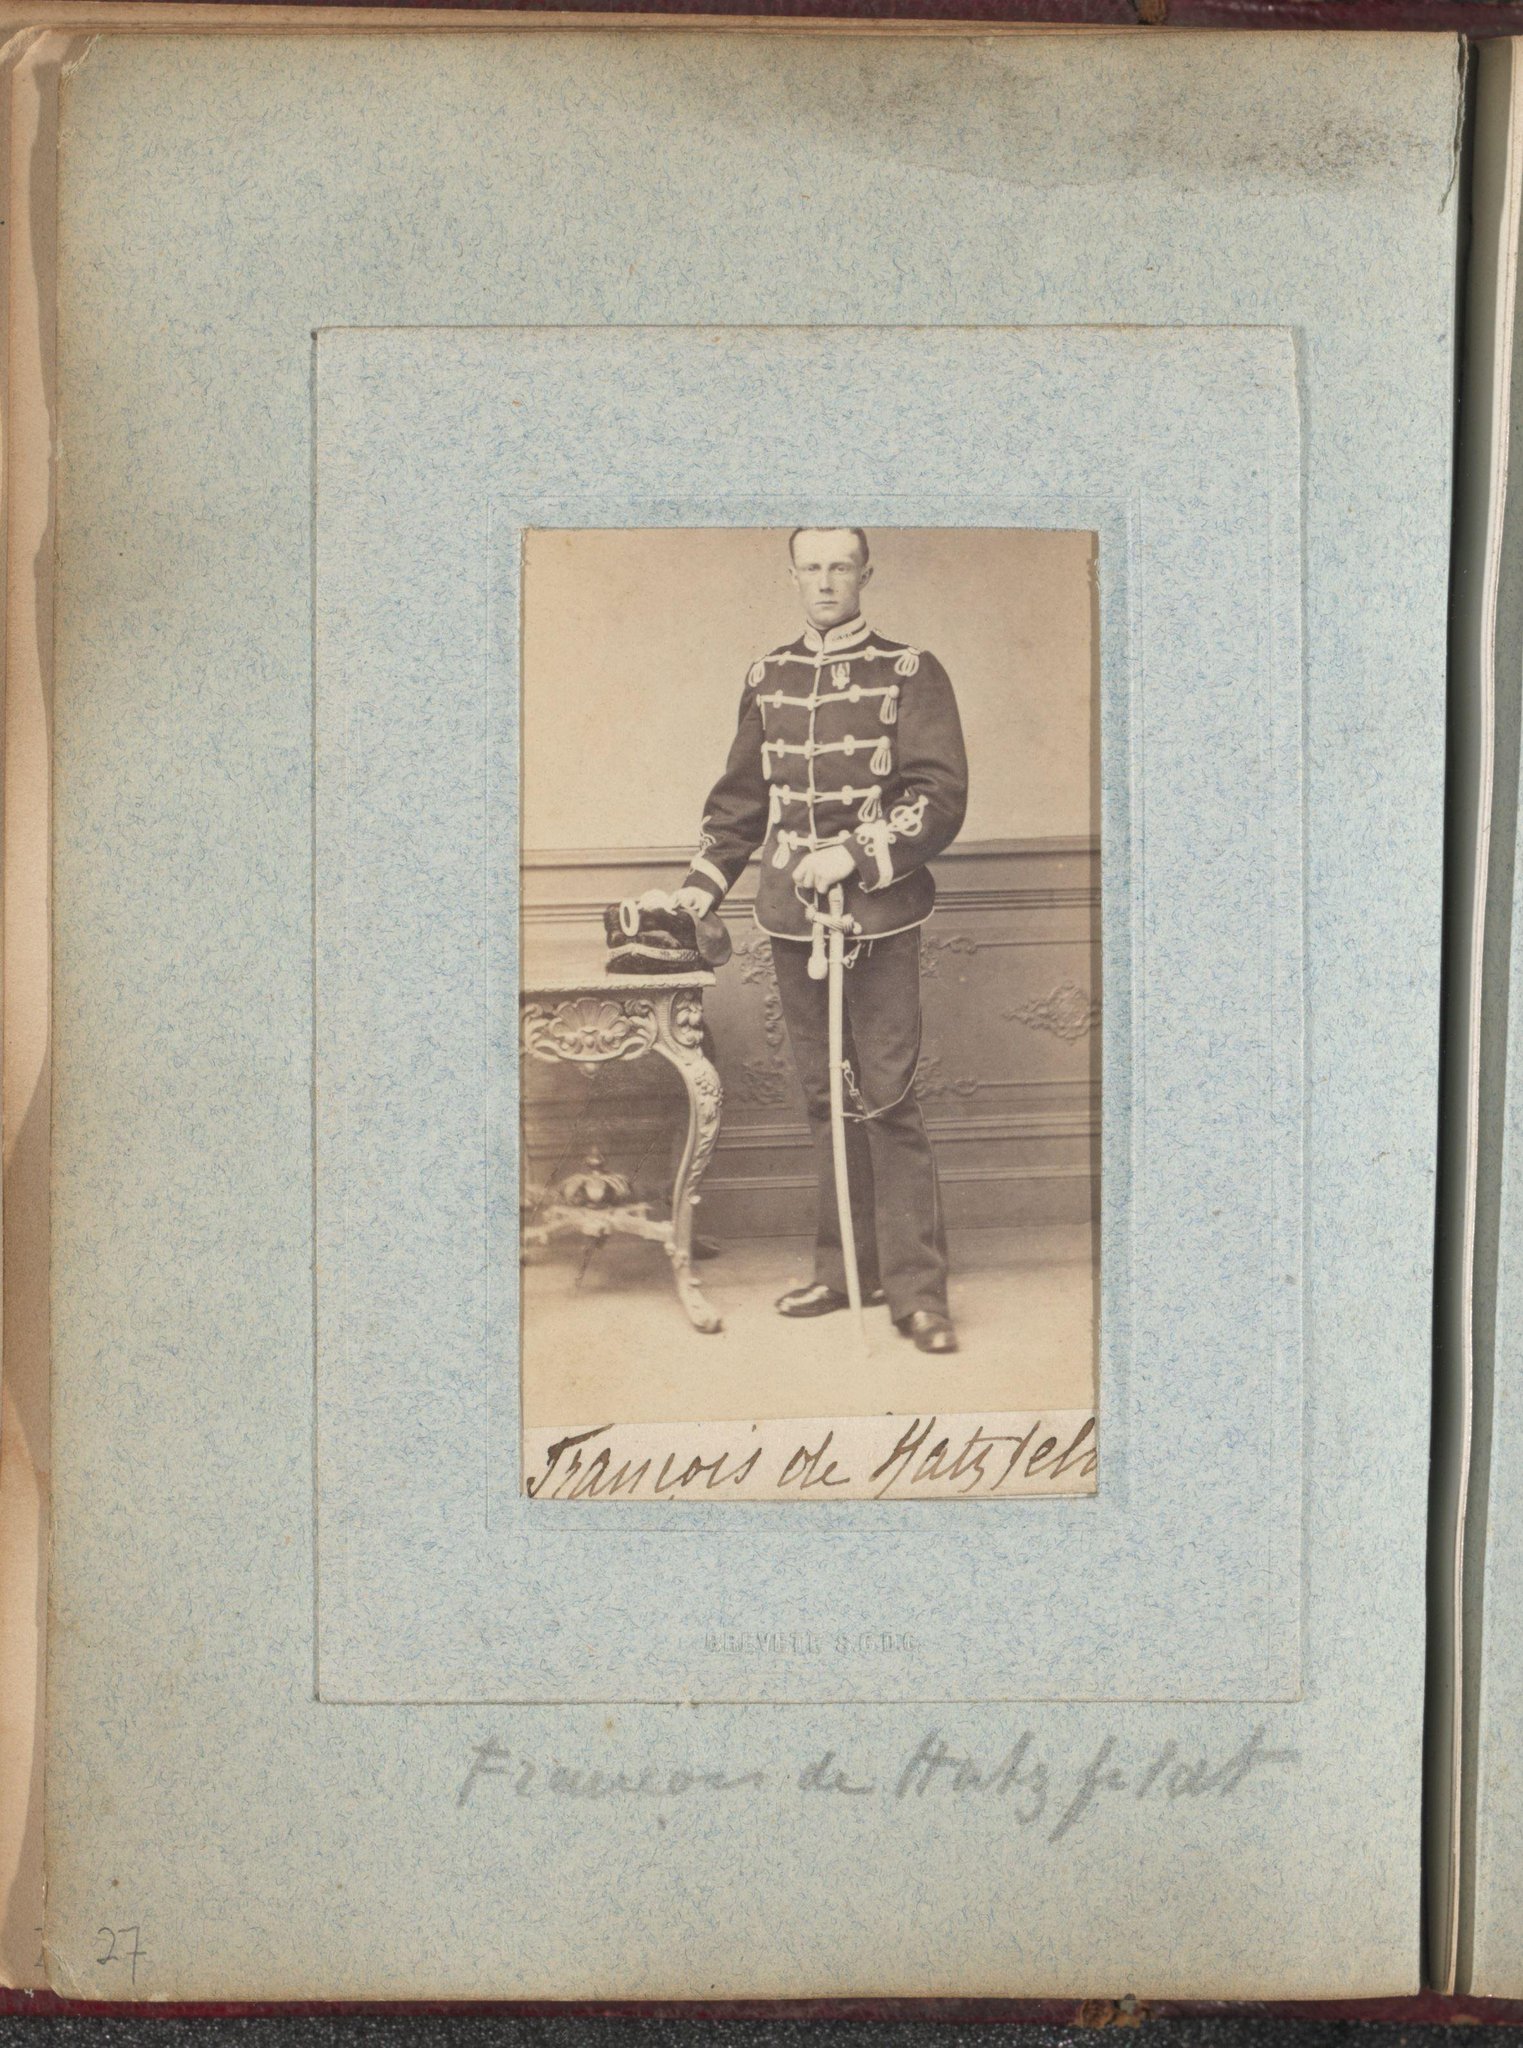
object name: carte de visite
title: François de Hatzfeldt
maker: raphael peters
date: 1860-1865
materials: cardboard, paper, photographic support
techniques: albumen print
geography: lüneburg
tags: studio requisites ~ photographer, trousers, breeches, hacking and thrusting weapons (with name), historical persons, head-gear: cap, shoes, sandals, (military) uniforms, coat, cape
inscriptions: name: ‘François de Hatzfeldt’, address: ‘Lüneburg Lünerthorstrasse No. 172.’, name: ‘François de Hatzfeldt’, dedication: ‘pour ma tante’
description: Onderdeel van Fotoalbum met 48 cartes-de-visite aangeboden aan maarschalk graaf De Castellane.